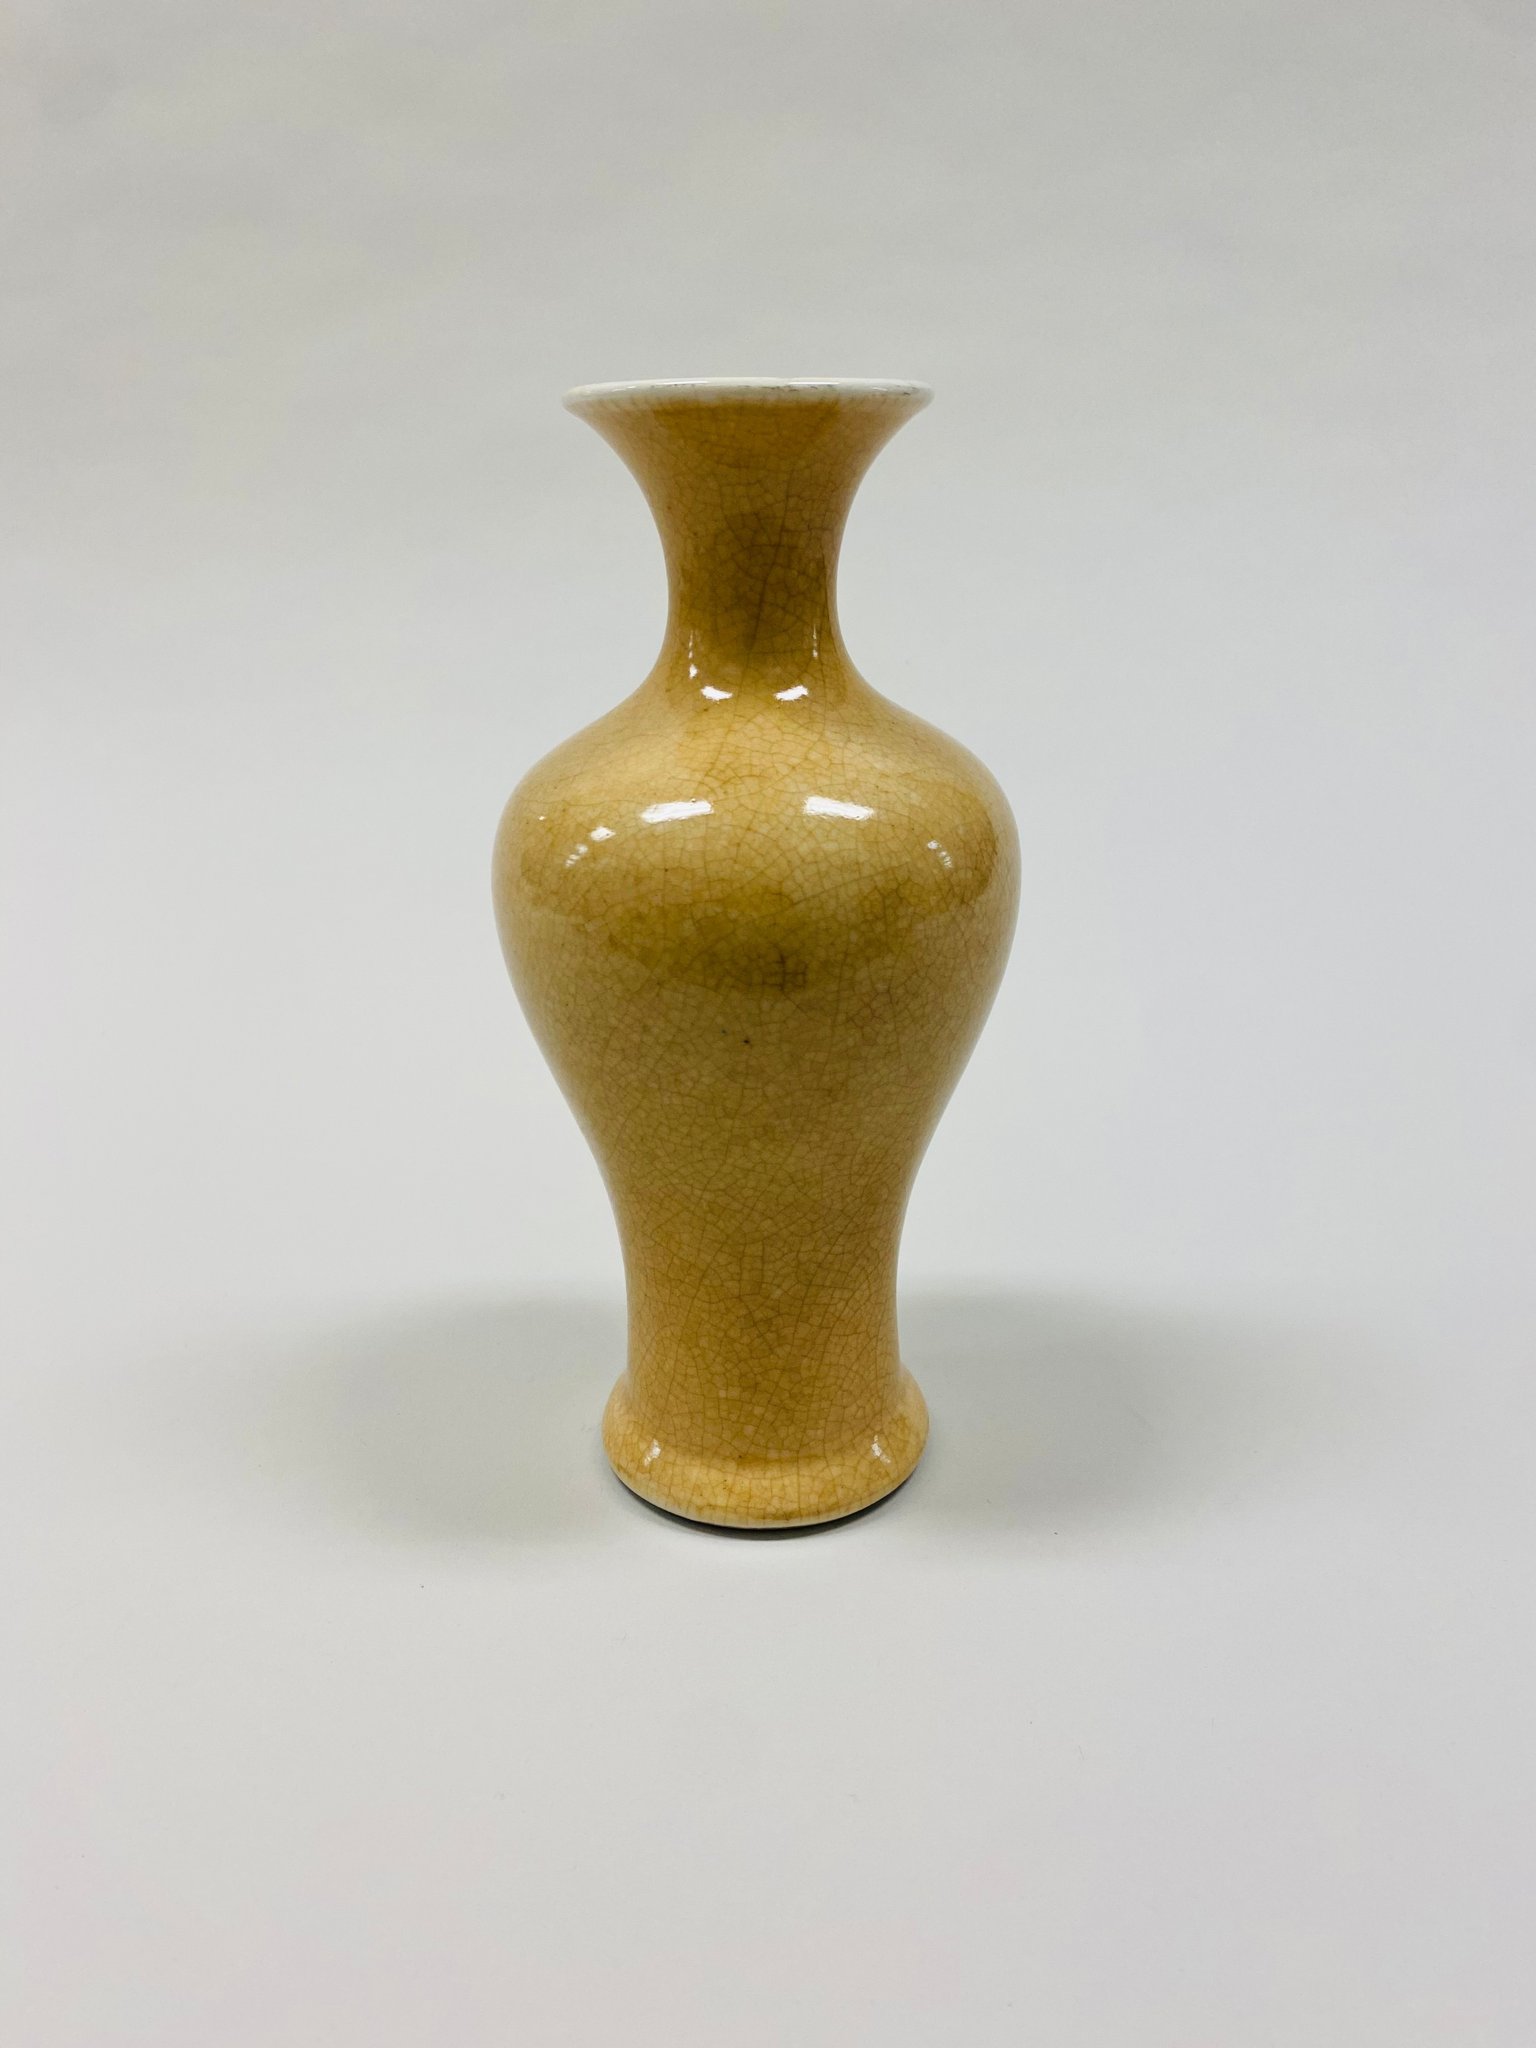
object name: vase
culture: chinese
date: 1767-1800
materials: glaze, porcelain